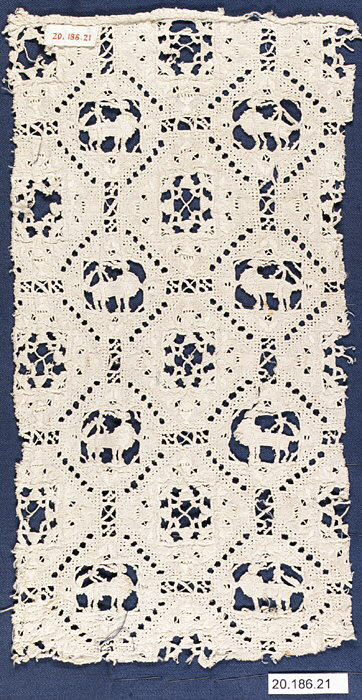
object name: strip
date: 1501-1700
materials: linen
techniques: embroidery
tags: animals